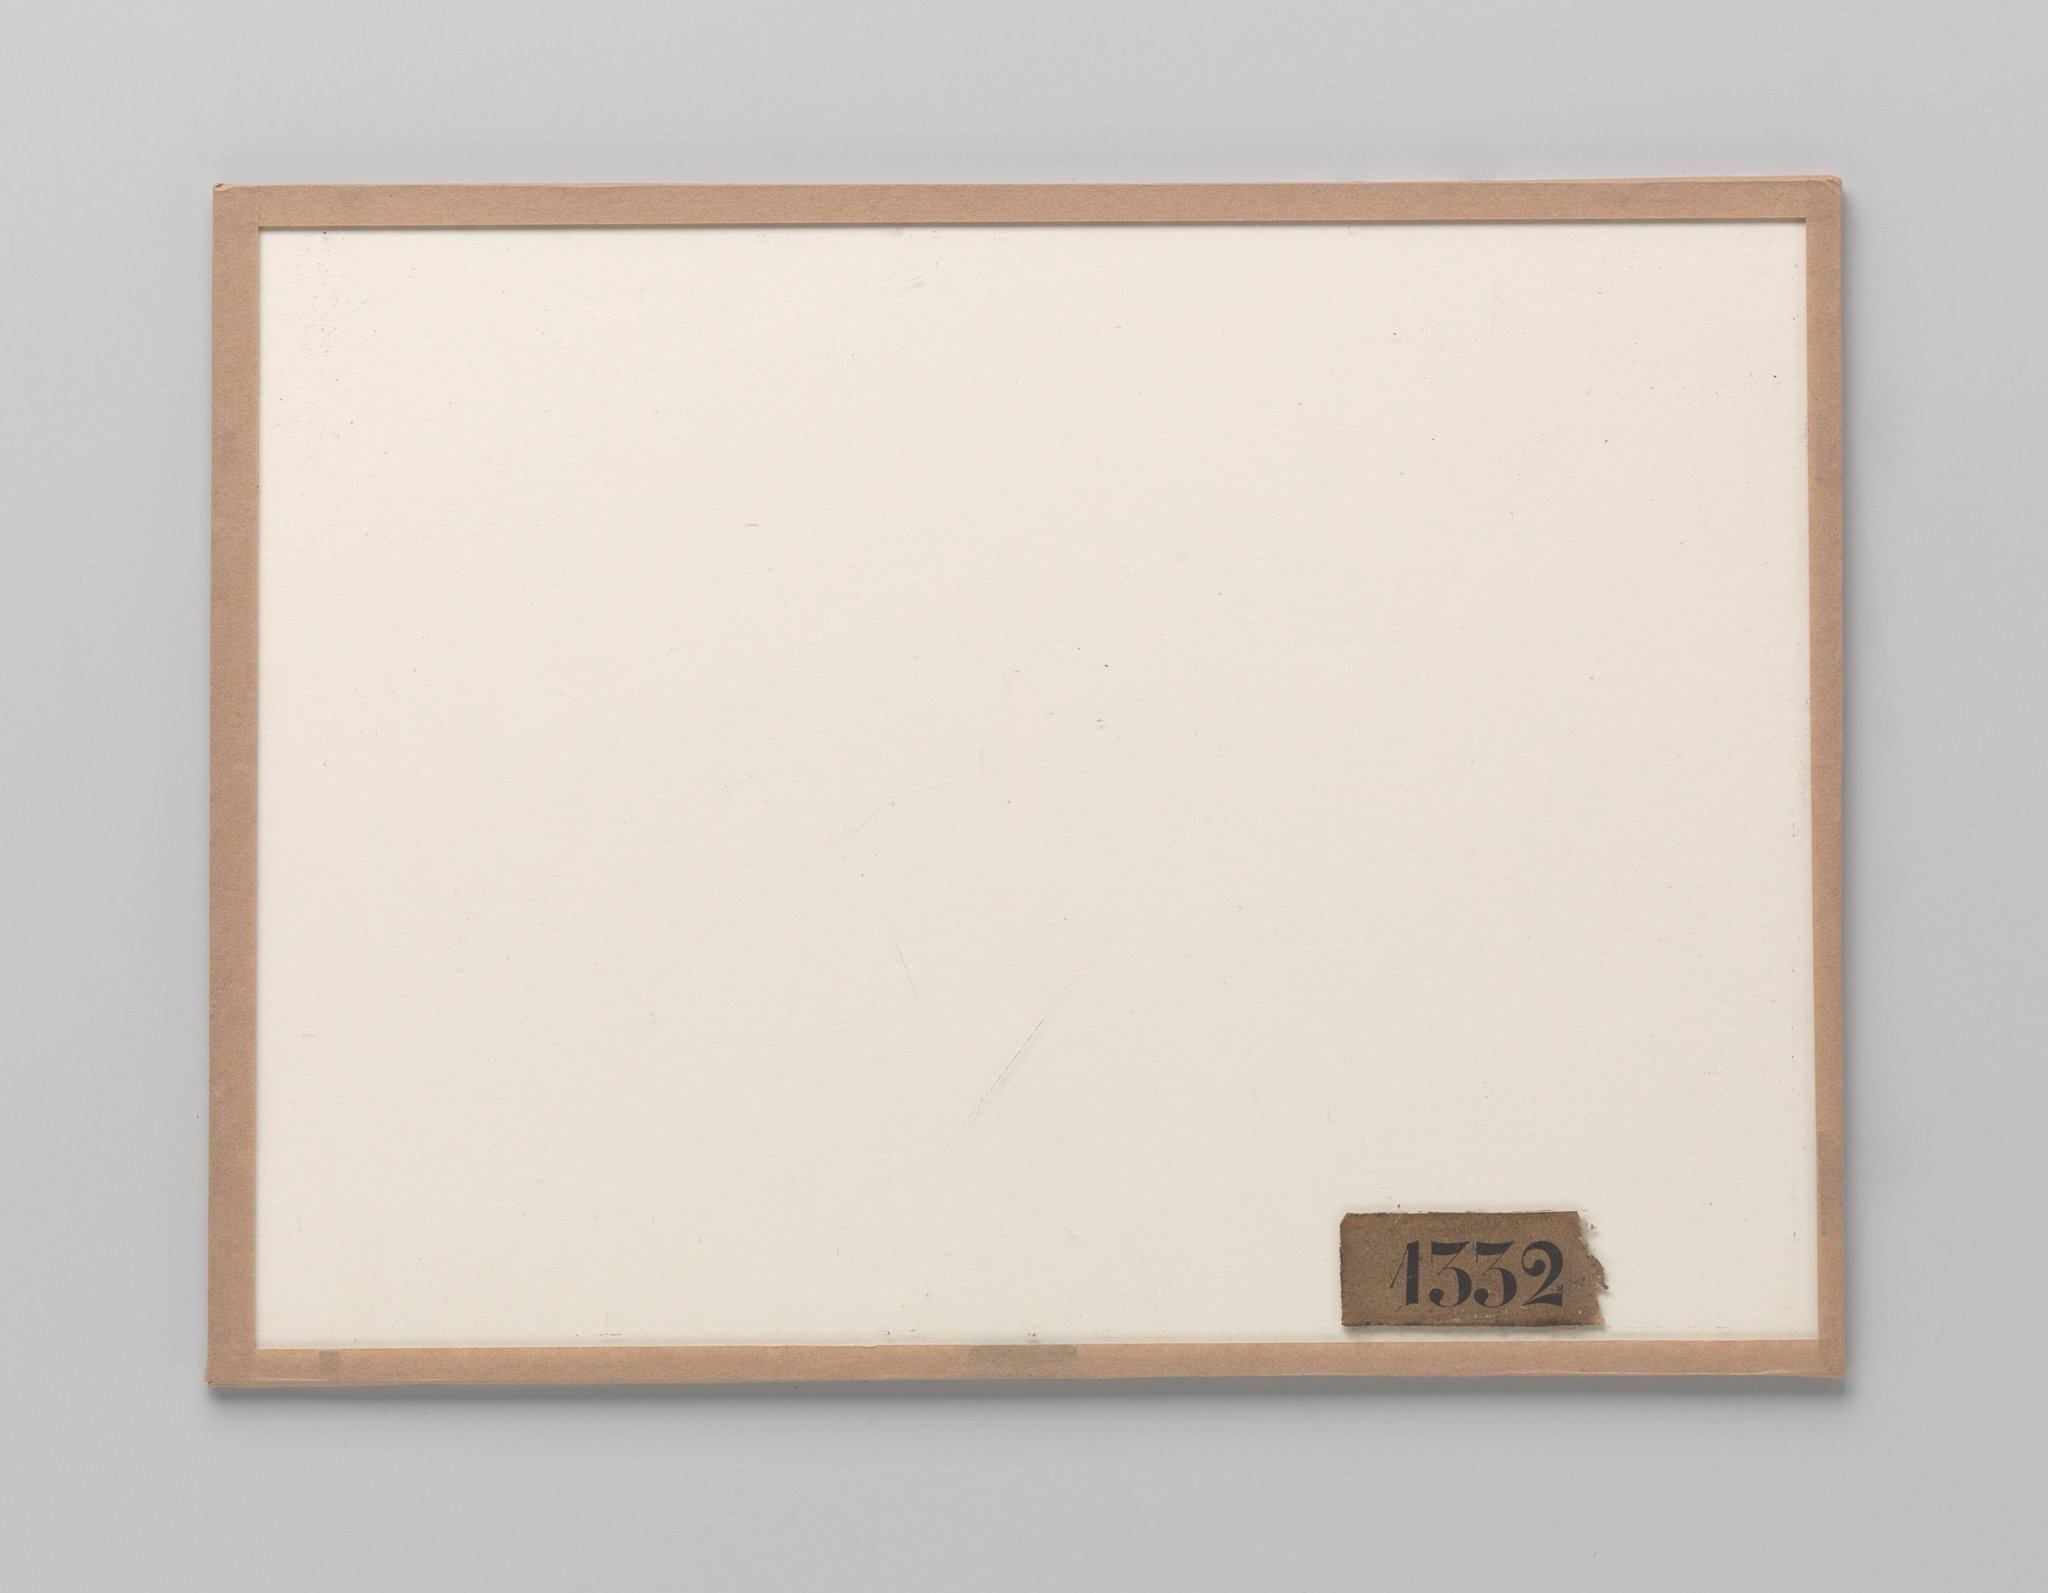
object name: frame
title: Picture Frame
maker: Anonymous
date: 1800-1883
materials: cardboard, glass, linen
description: Lijst behorend bij foto van een groep medewerkers van het Rode Kruis.